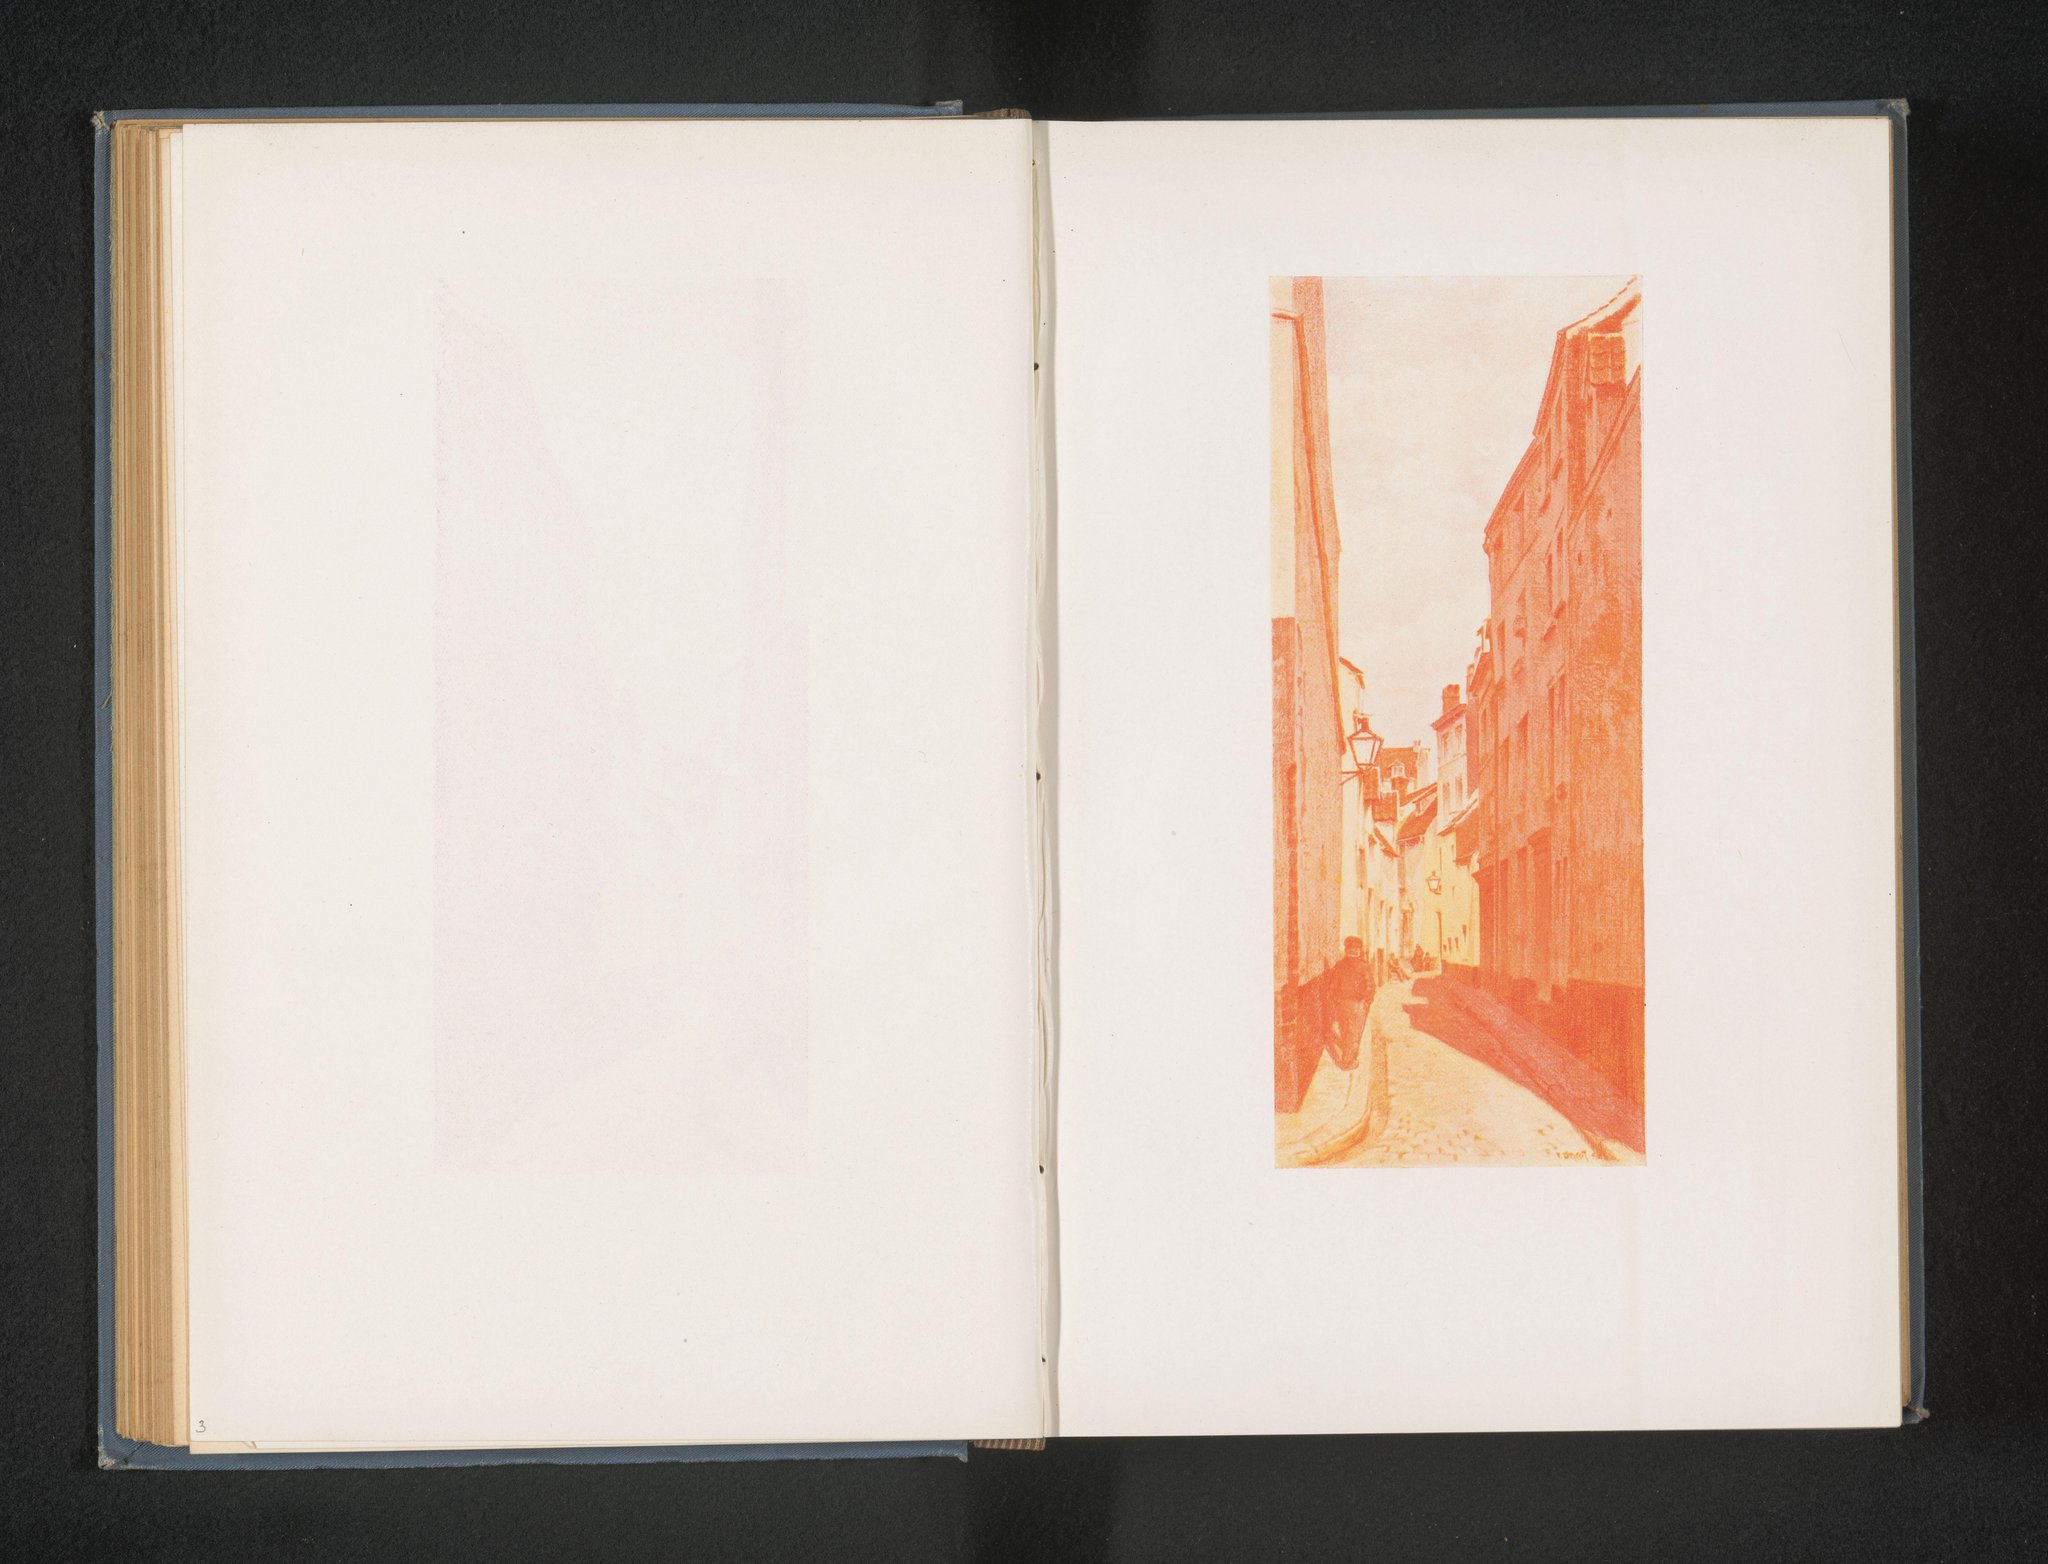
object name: photomechanical print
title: Tweede drukgang van een driekleurenautotypie, afgebeeld een gezicht op een straat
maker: Anonymous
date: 1899-1904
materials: paper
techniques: two-color autotype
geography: brussels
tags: street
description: Prent op vijfde ongenummerde pagina na pagina 64.